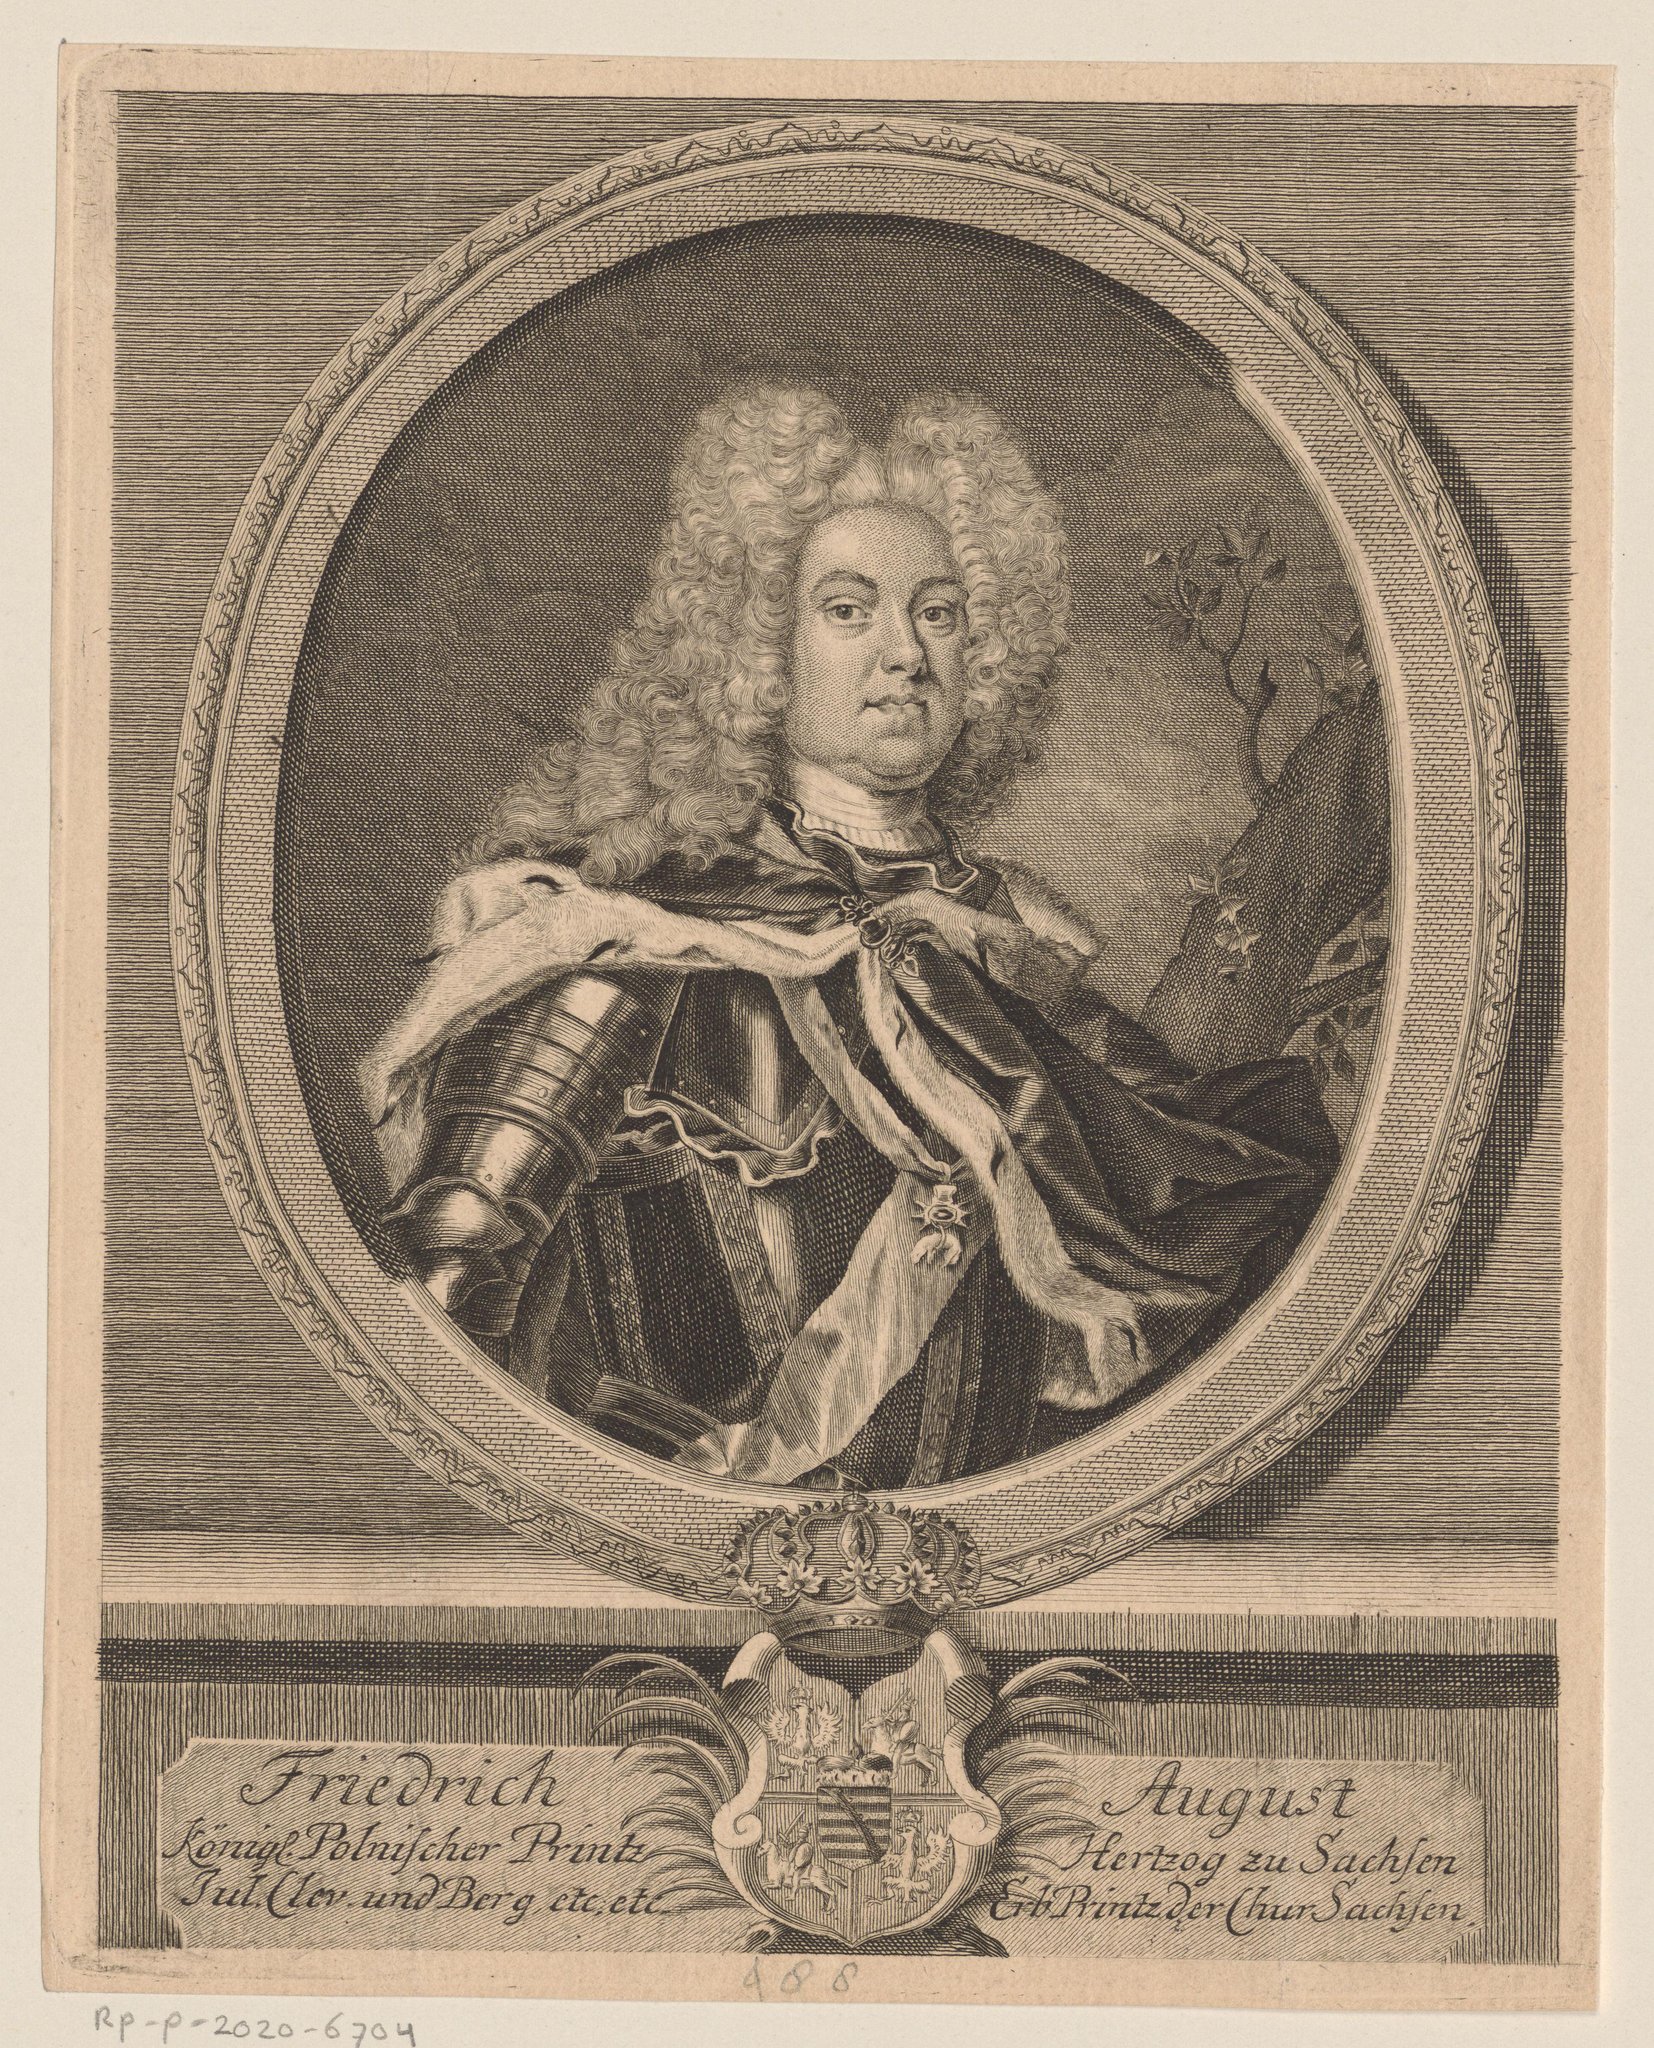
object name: print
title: Portret van August III van Polen als prins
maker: Anonymous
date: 1720-1733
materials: paper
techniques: engraving, etching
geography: germany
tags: augustus iii (king of poland), coat of arms (symbol of sovereignty), armour, historical persons, knighthood order of the golden fleece, king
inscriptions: inscription: ‘Hertog’